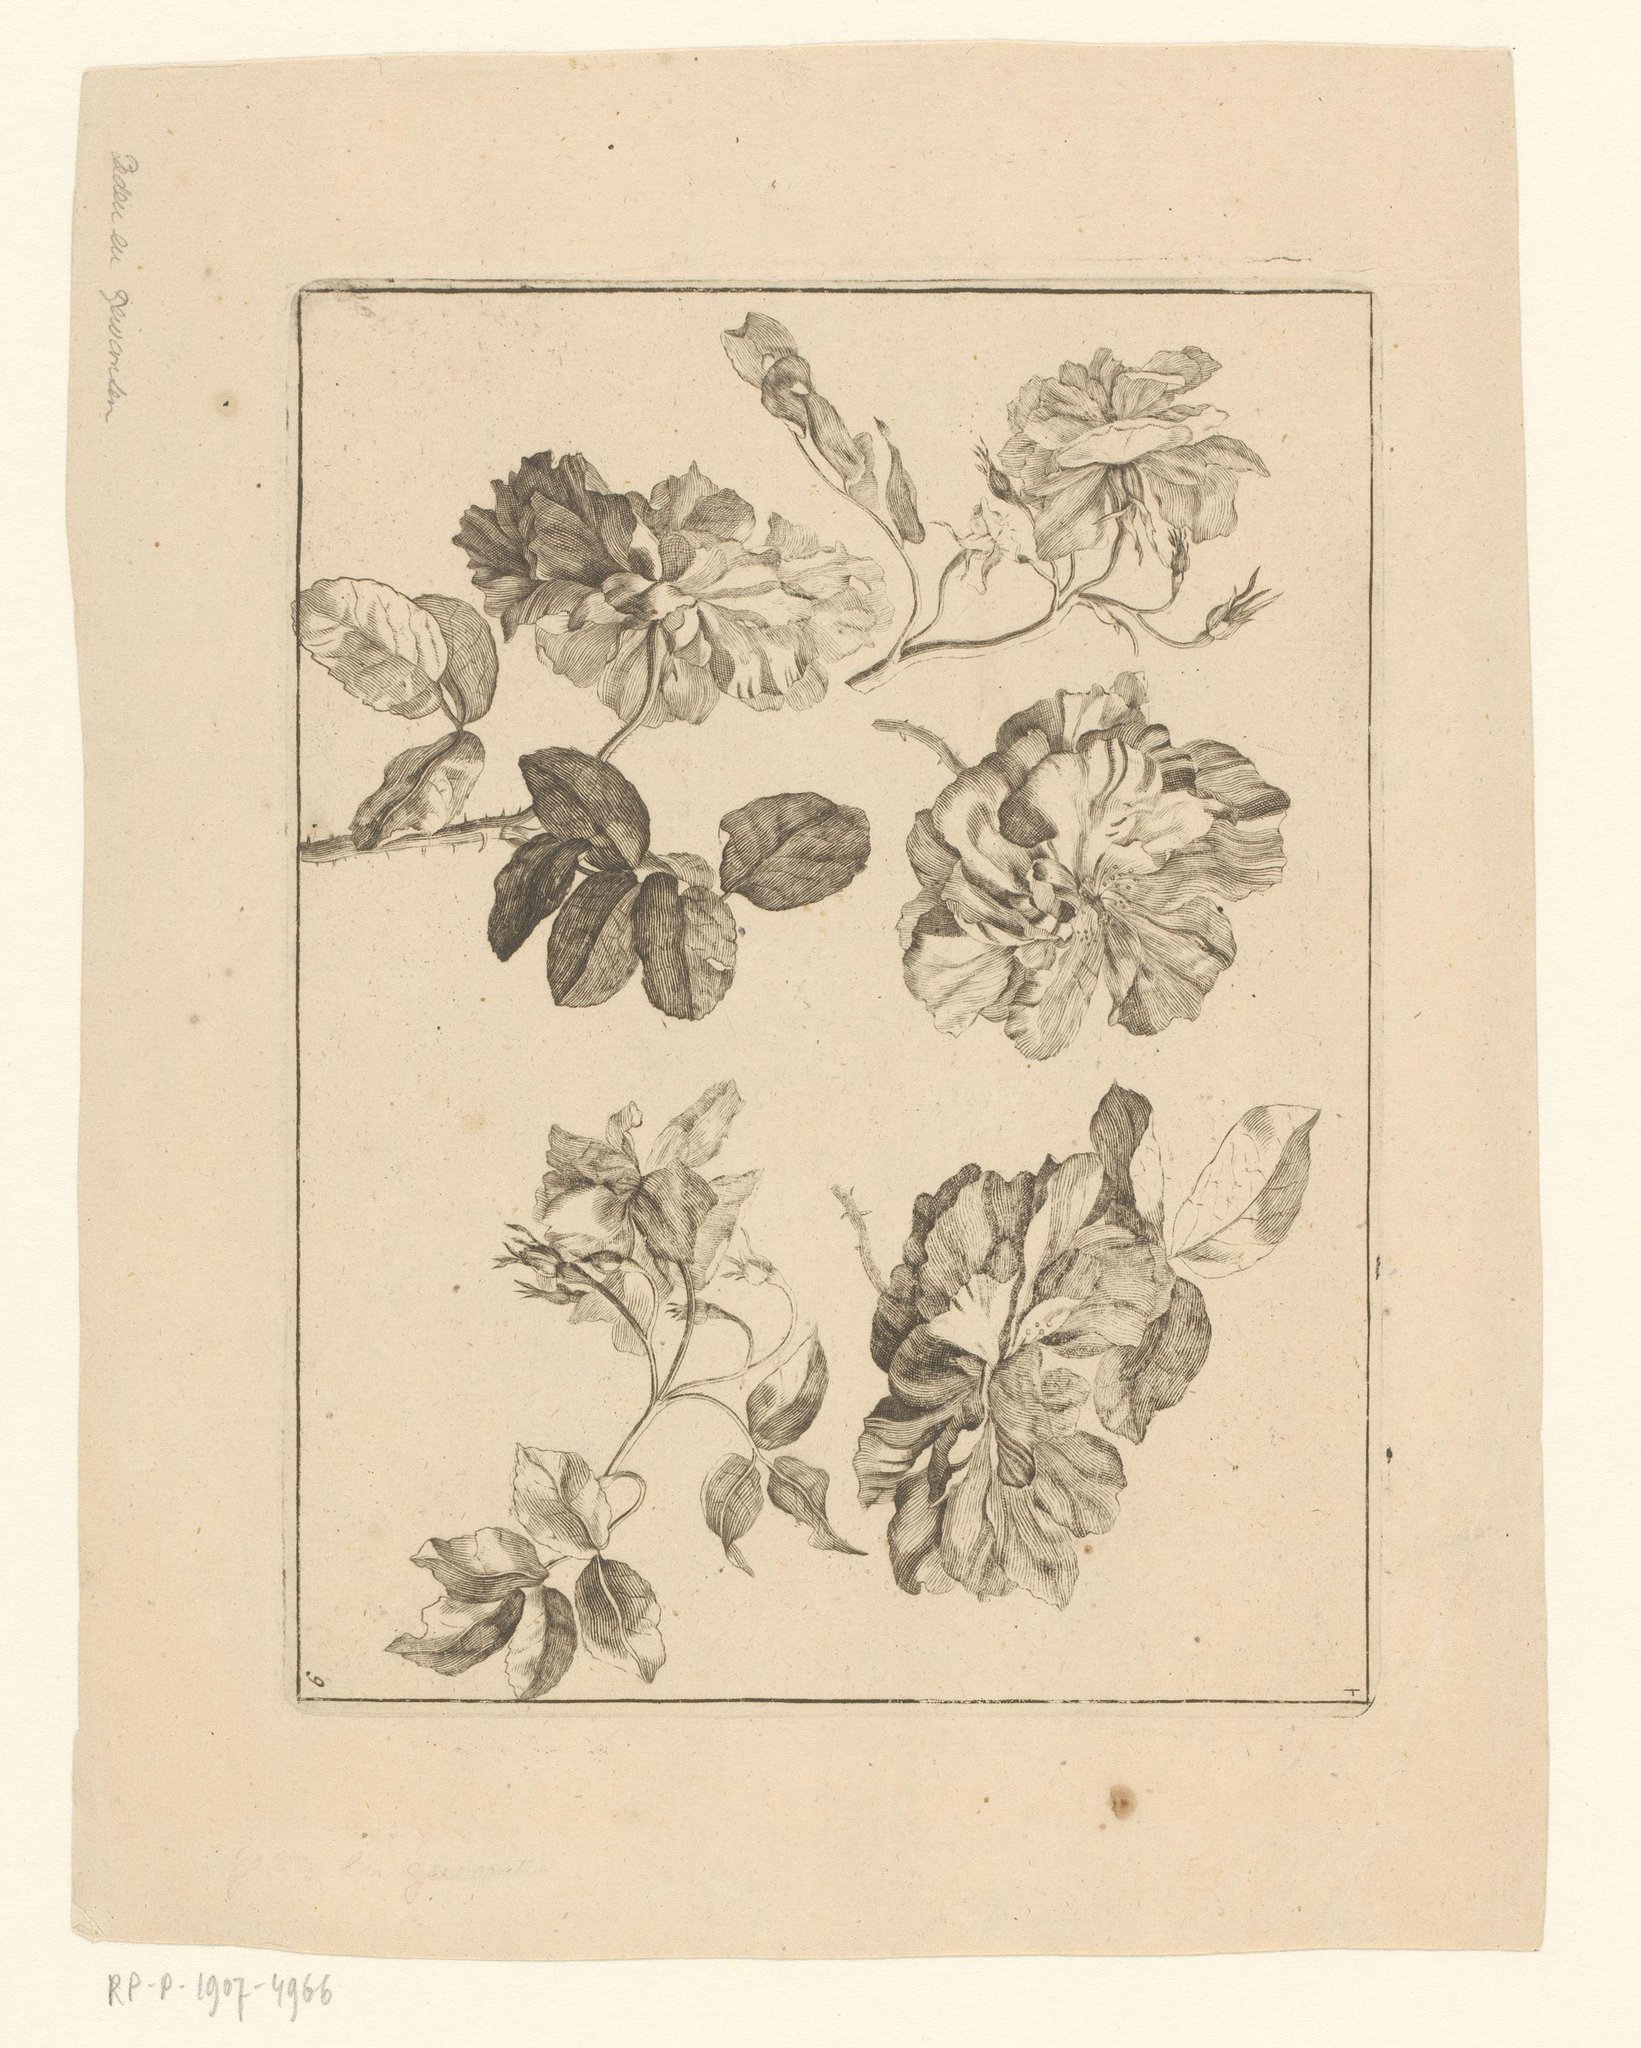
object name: print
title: Pioenrozen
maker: Anonymous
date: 1700-1770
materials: paper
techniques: etching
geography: netherlands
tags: flowers: rose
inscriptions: collector's mark: Lugt 2228